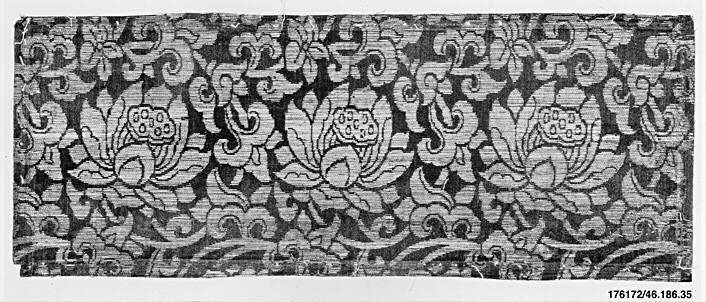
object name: sutra cover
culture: chinese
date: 1601-1700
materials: metal thread, silk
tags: lotuses